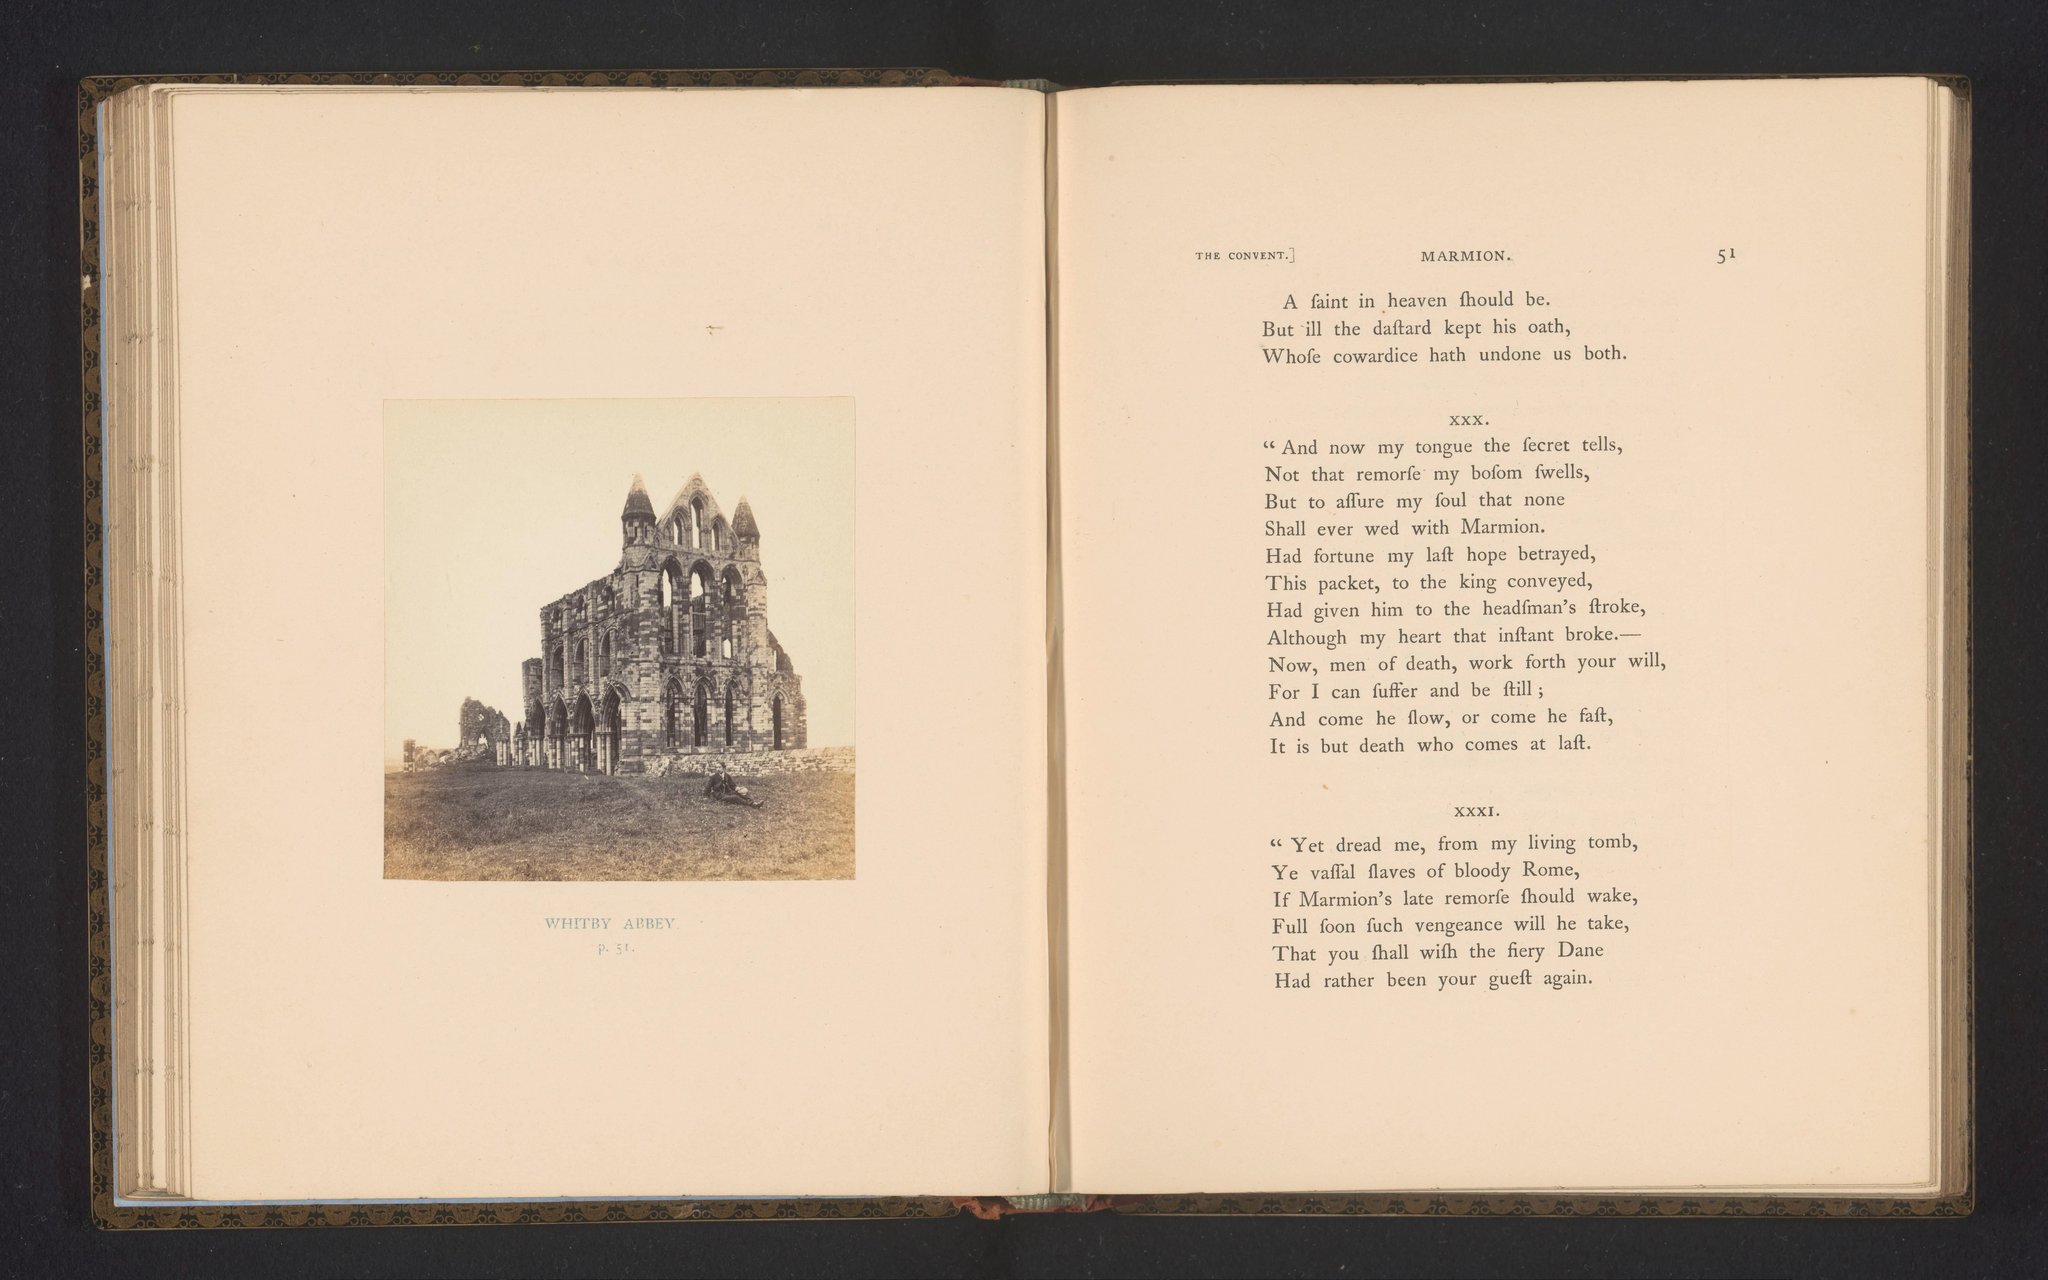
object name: page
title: Whitby Abbey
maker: thomas annan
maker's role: fotograaf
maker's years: 1829-1887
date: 1856-1866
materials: photographic support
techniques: albumen print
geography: whitby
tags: ruin of church, monastery, etc.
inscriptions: inscription: ‘p. 51.’